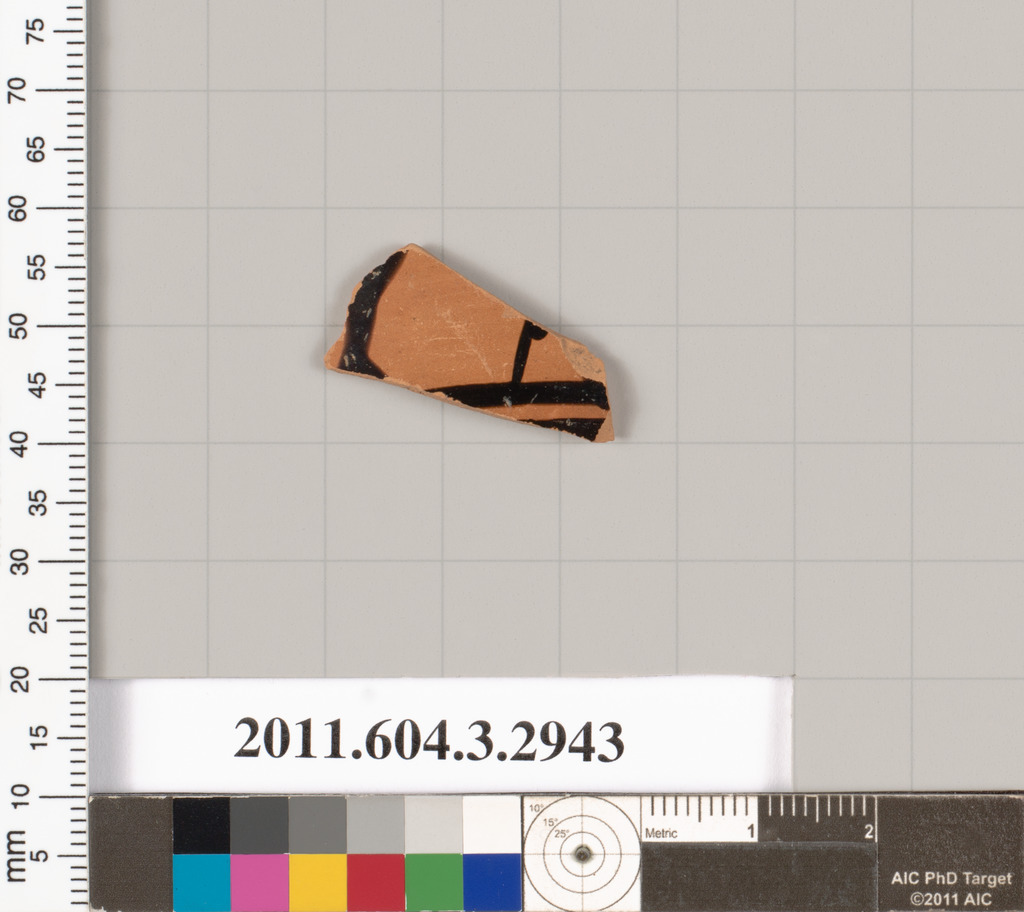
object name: kylix fragment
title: Terracotta fragment of a kylix (drinking cup)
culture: greek, attic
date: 534-468 BCE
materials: terracotta